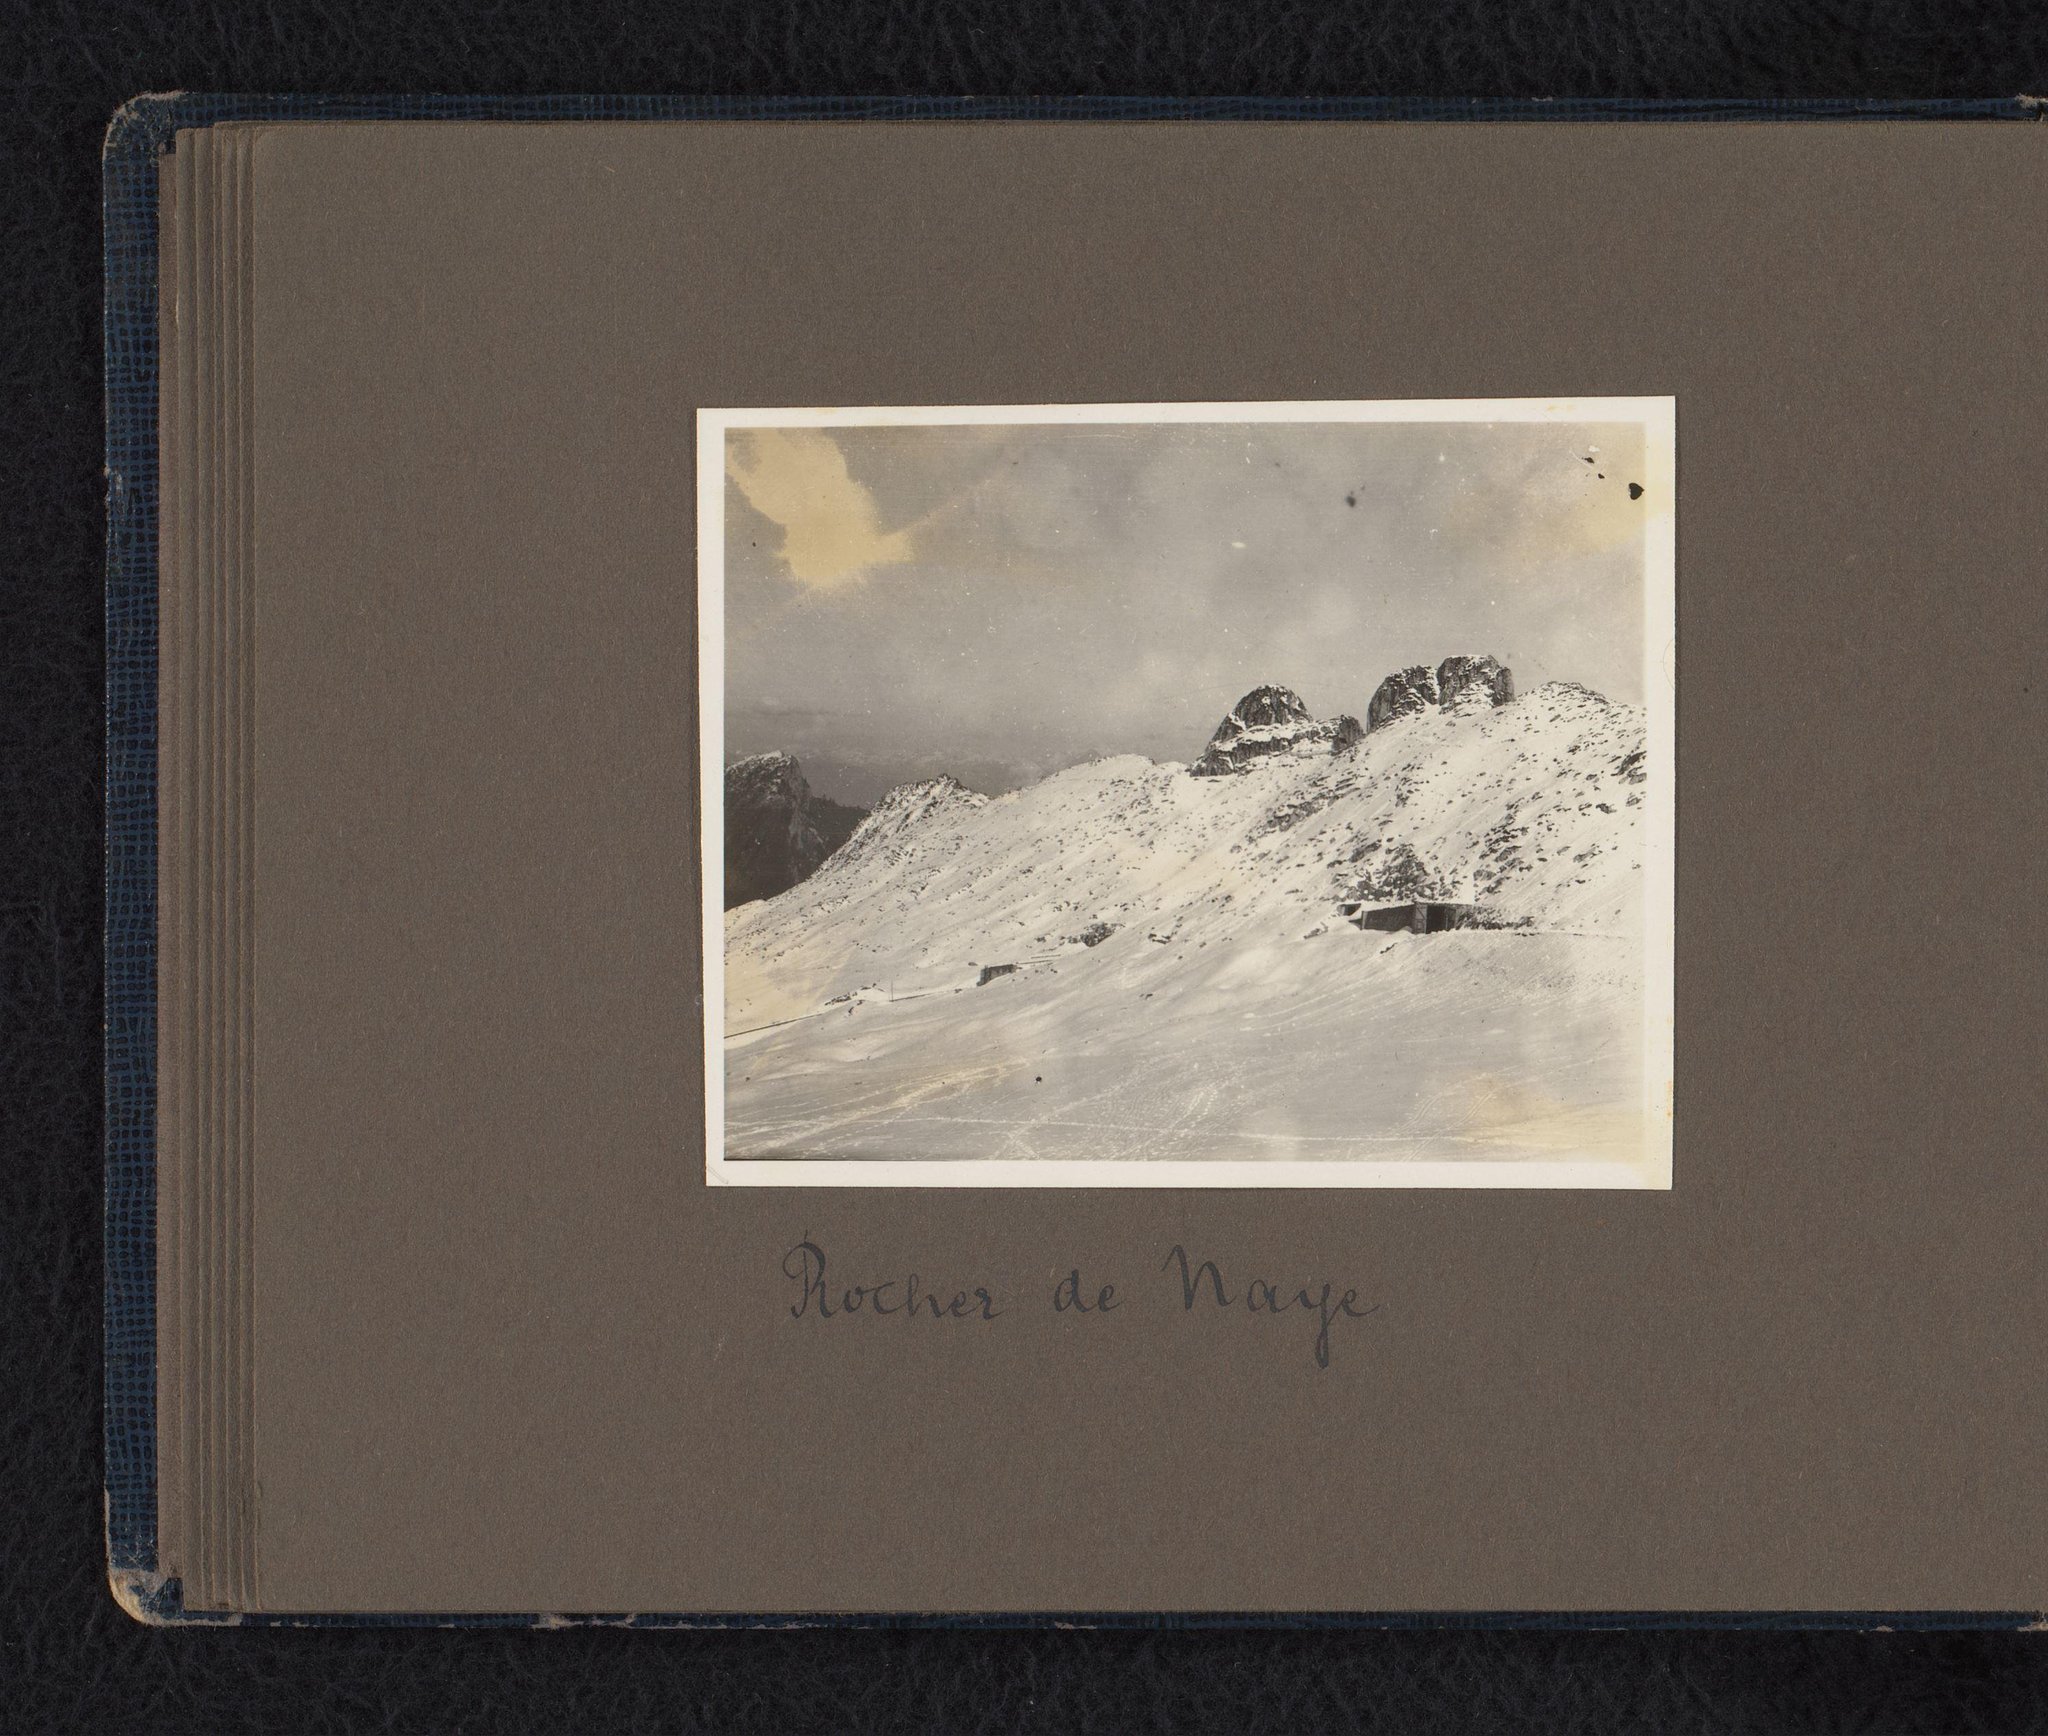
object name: album leaf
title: Berg Rocher de Naye, tijdens een vakantie van Eugen Wachenheimer en zijn echtgenote Else Wachenheimer-Moos door Zwitserland, augustus 1927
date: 1908-1927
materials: paper, photographic support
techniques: gelatin silver print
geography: switzerland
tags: mountain-range, snow peaks, switzerland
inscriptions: inscription: ‘Rocher de Naye’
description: Albumblad bevat een foto van landschap zonder personen. Uit album half formaat, blauw kunstlederen omslag met koordbinding.